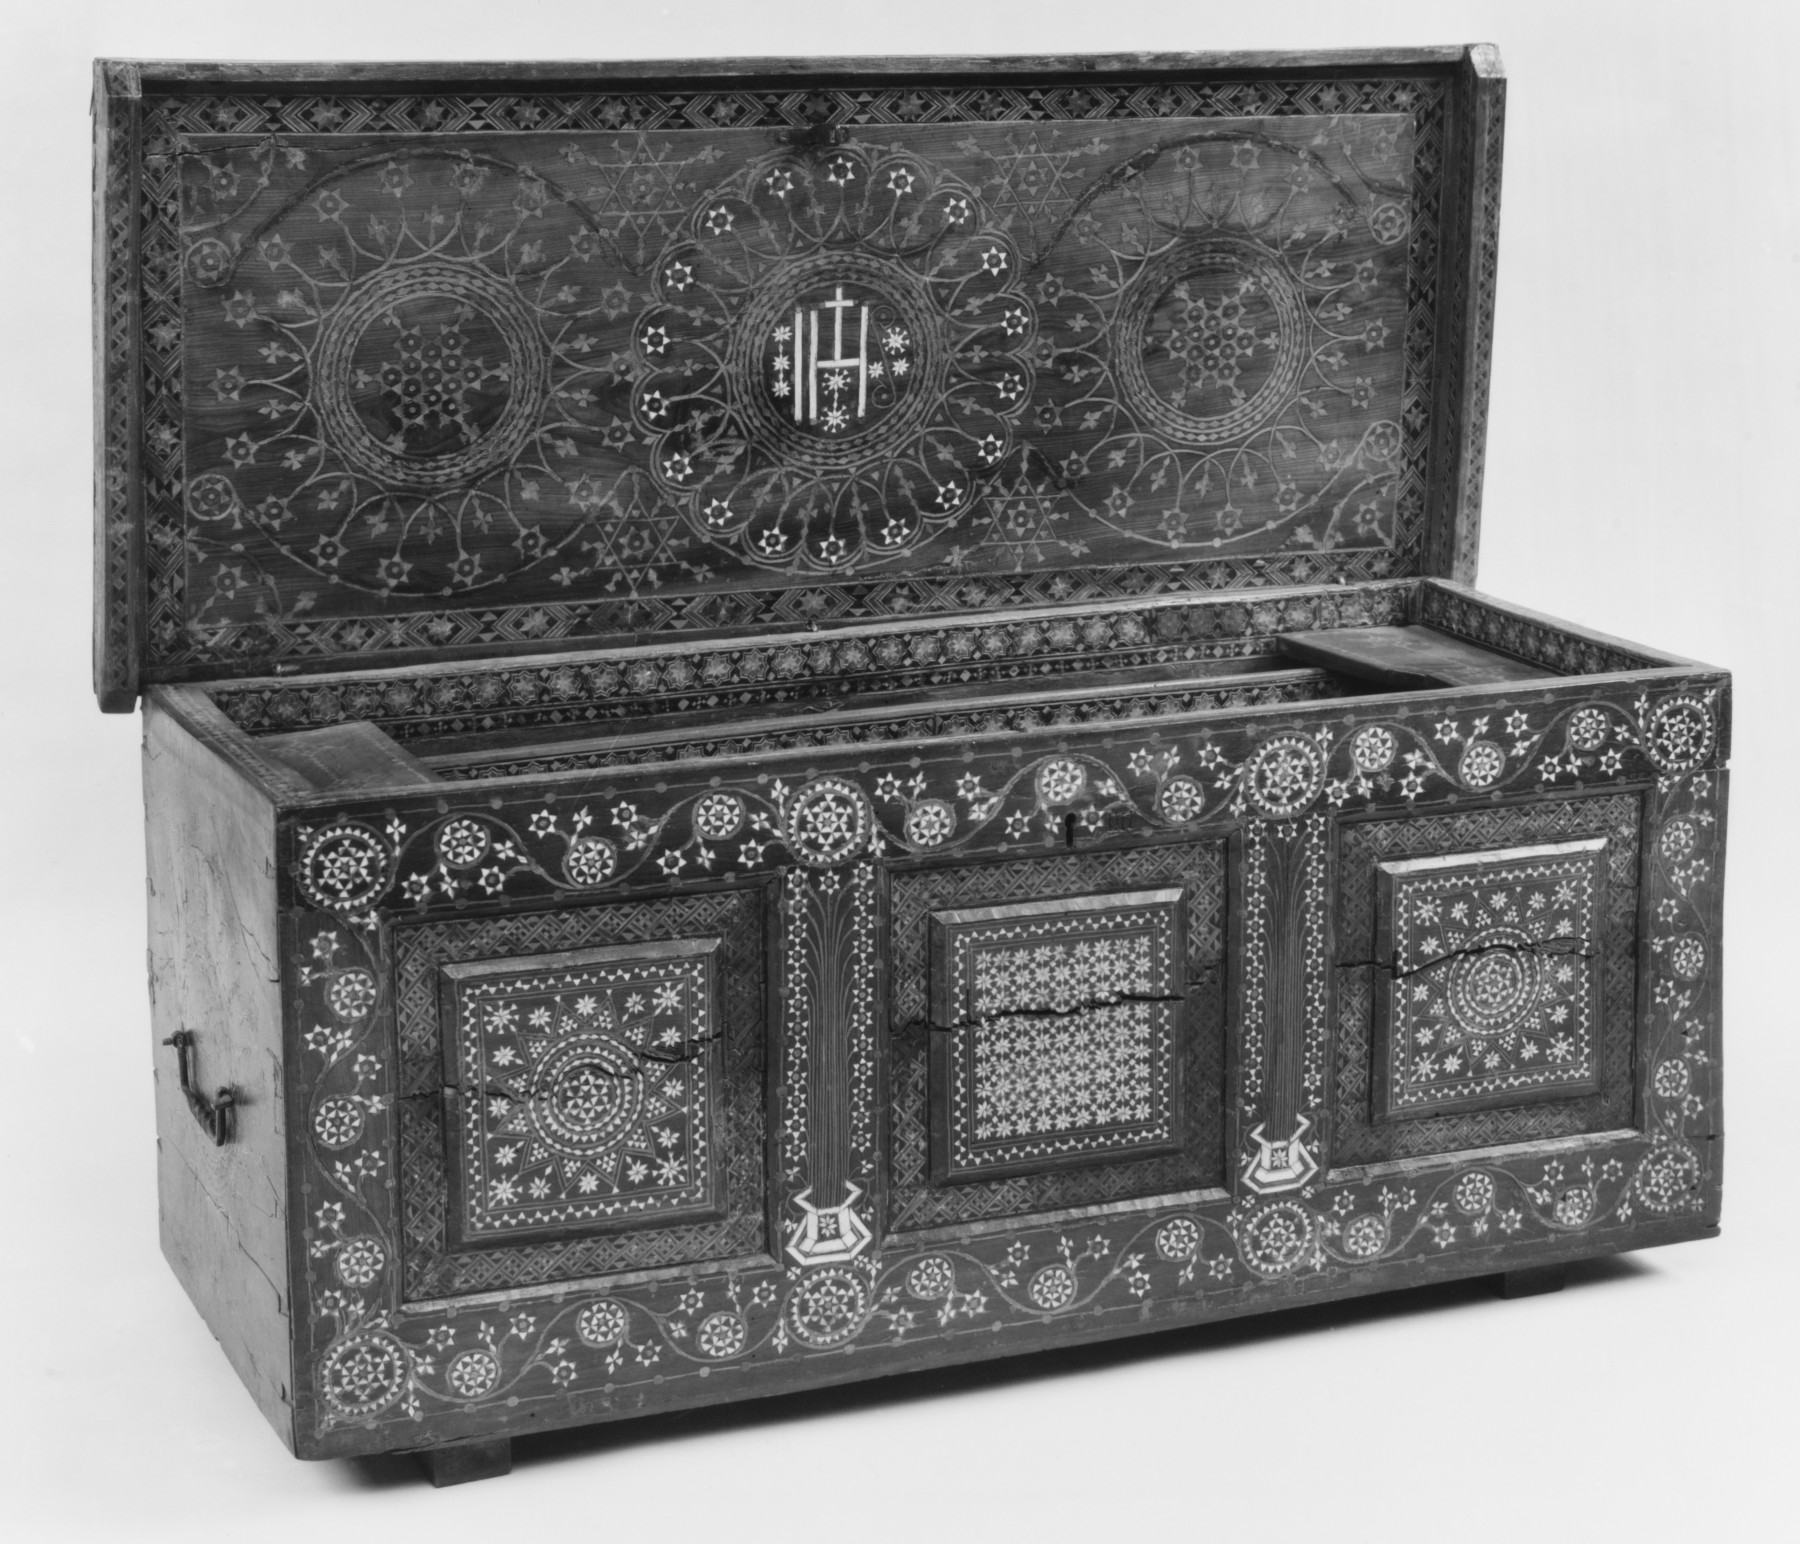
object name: chest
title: Chest (cassone)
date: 1467-1500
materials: bone, ivory, wood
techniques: inlay